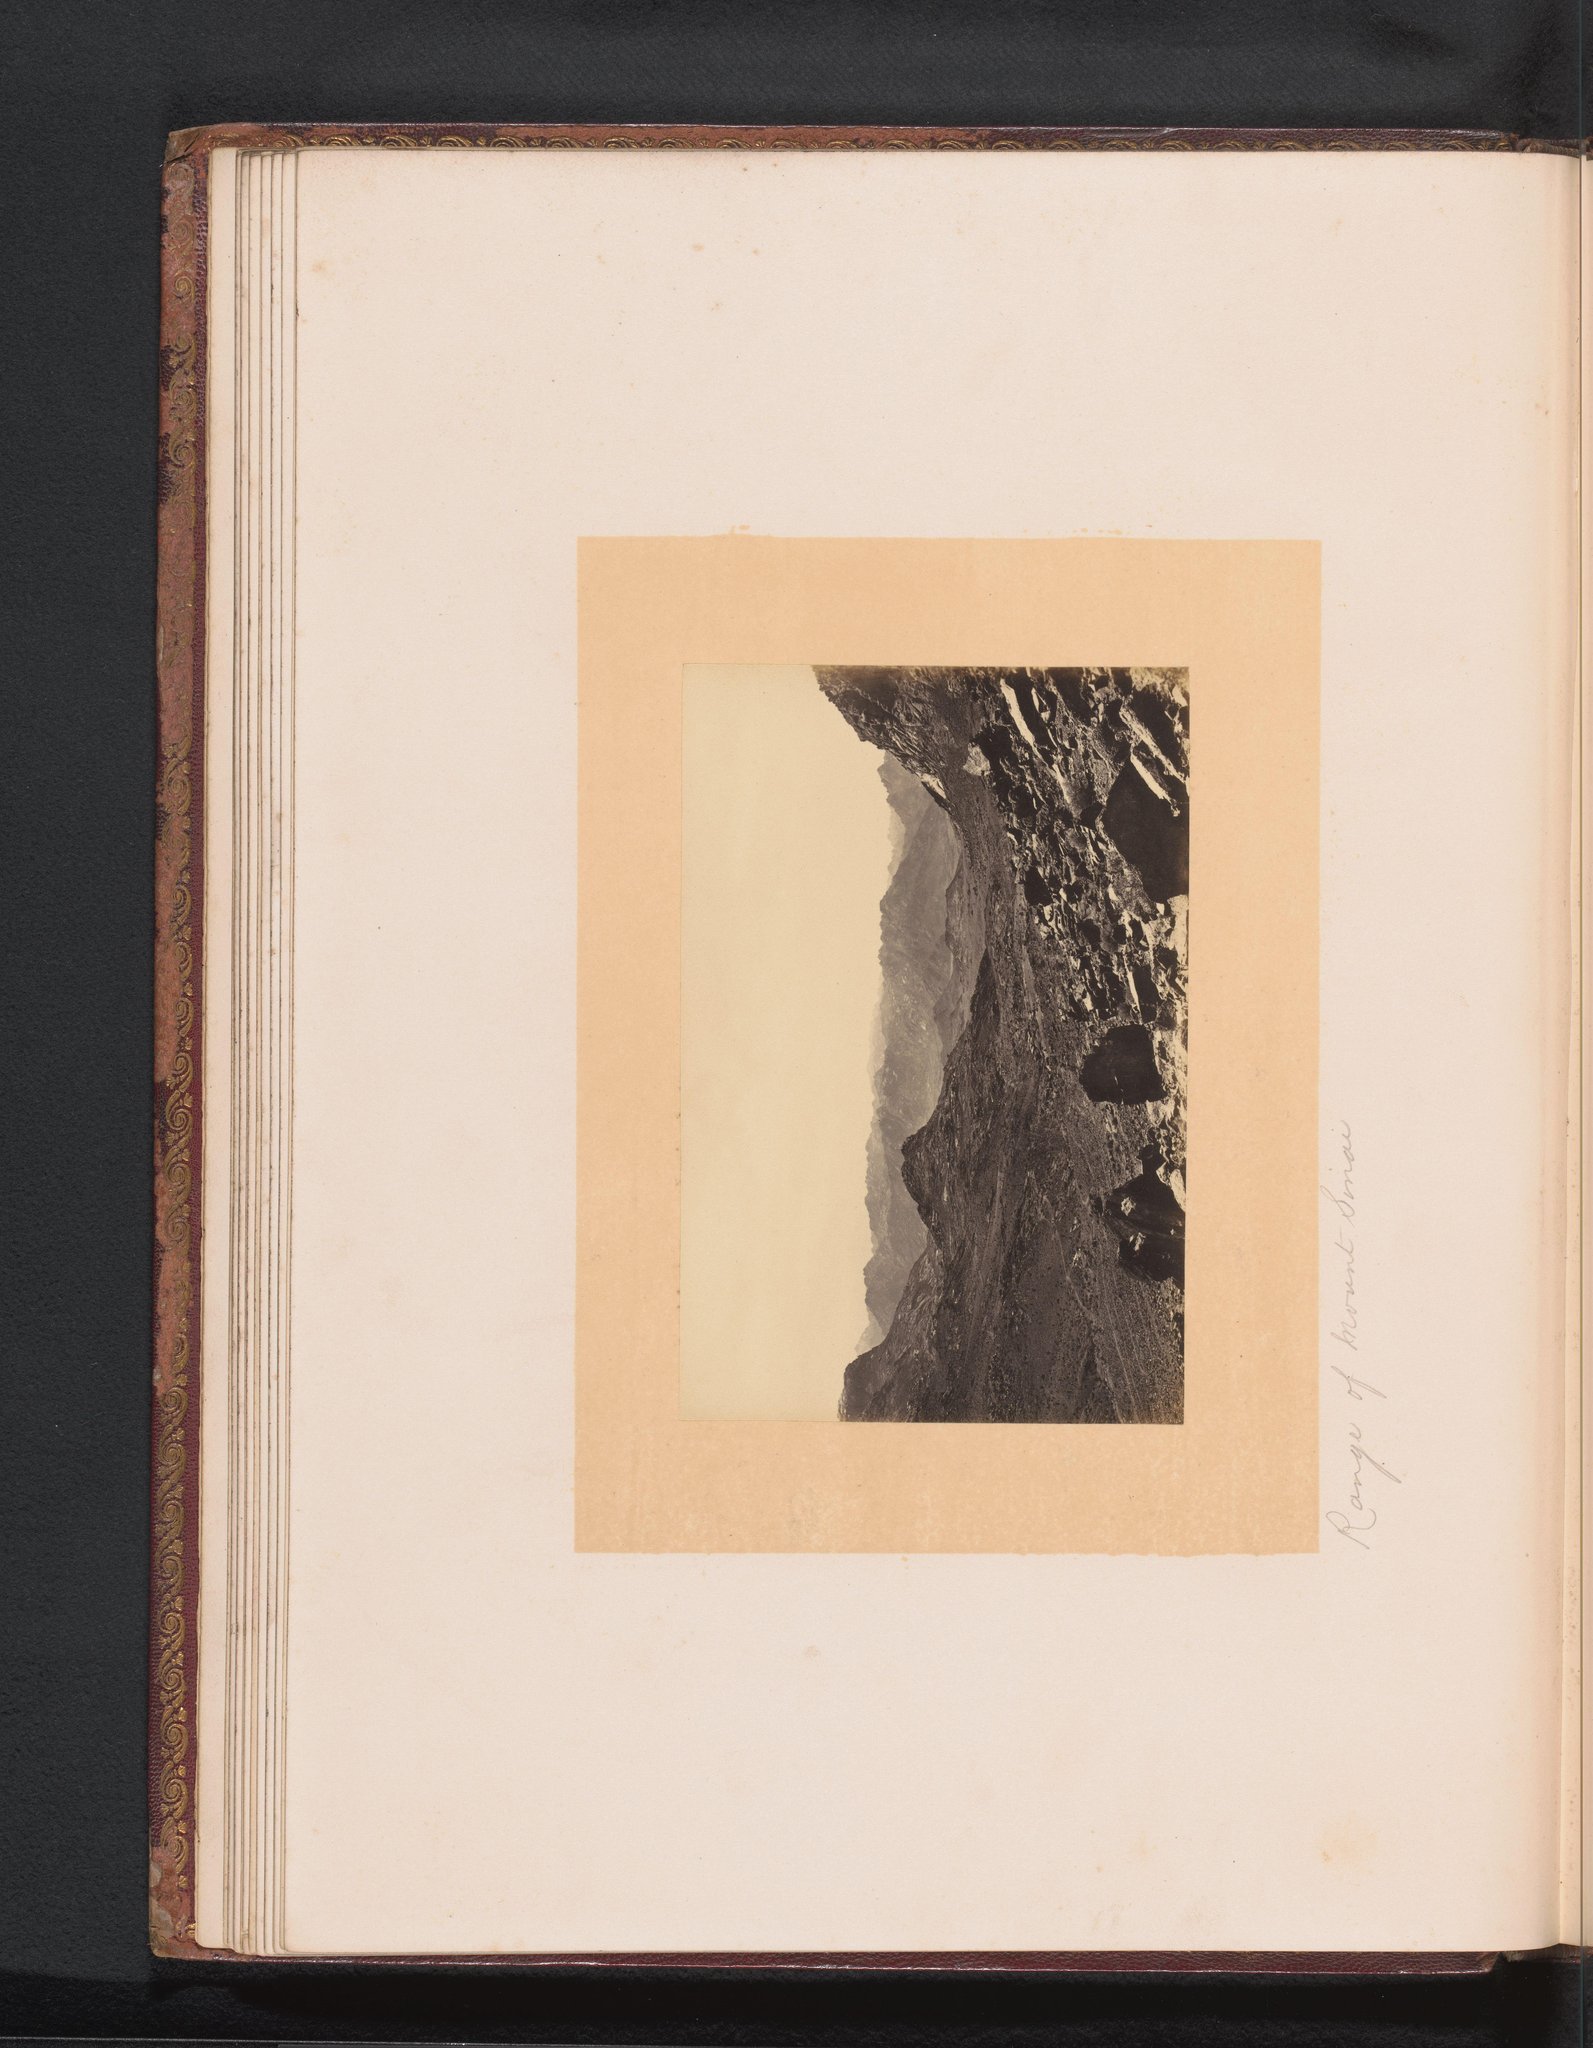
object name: photograph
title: Gezicht op het Sinaïgebergte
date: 1870-1875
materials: photographic support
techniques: albumen print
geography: sinai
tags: mountain-range, snow peaks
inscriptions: annotation: ‘Range of Mount Sinaï’